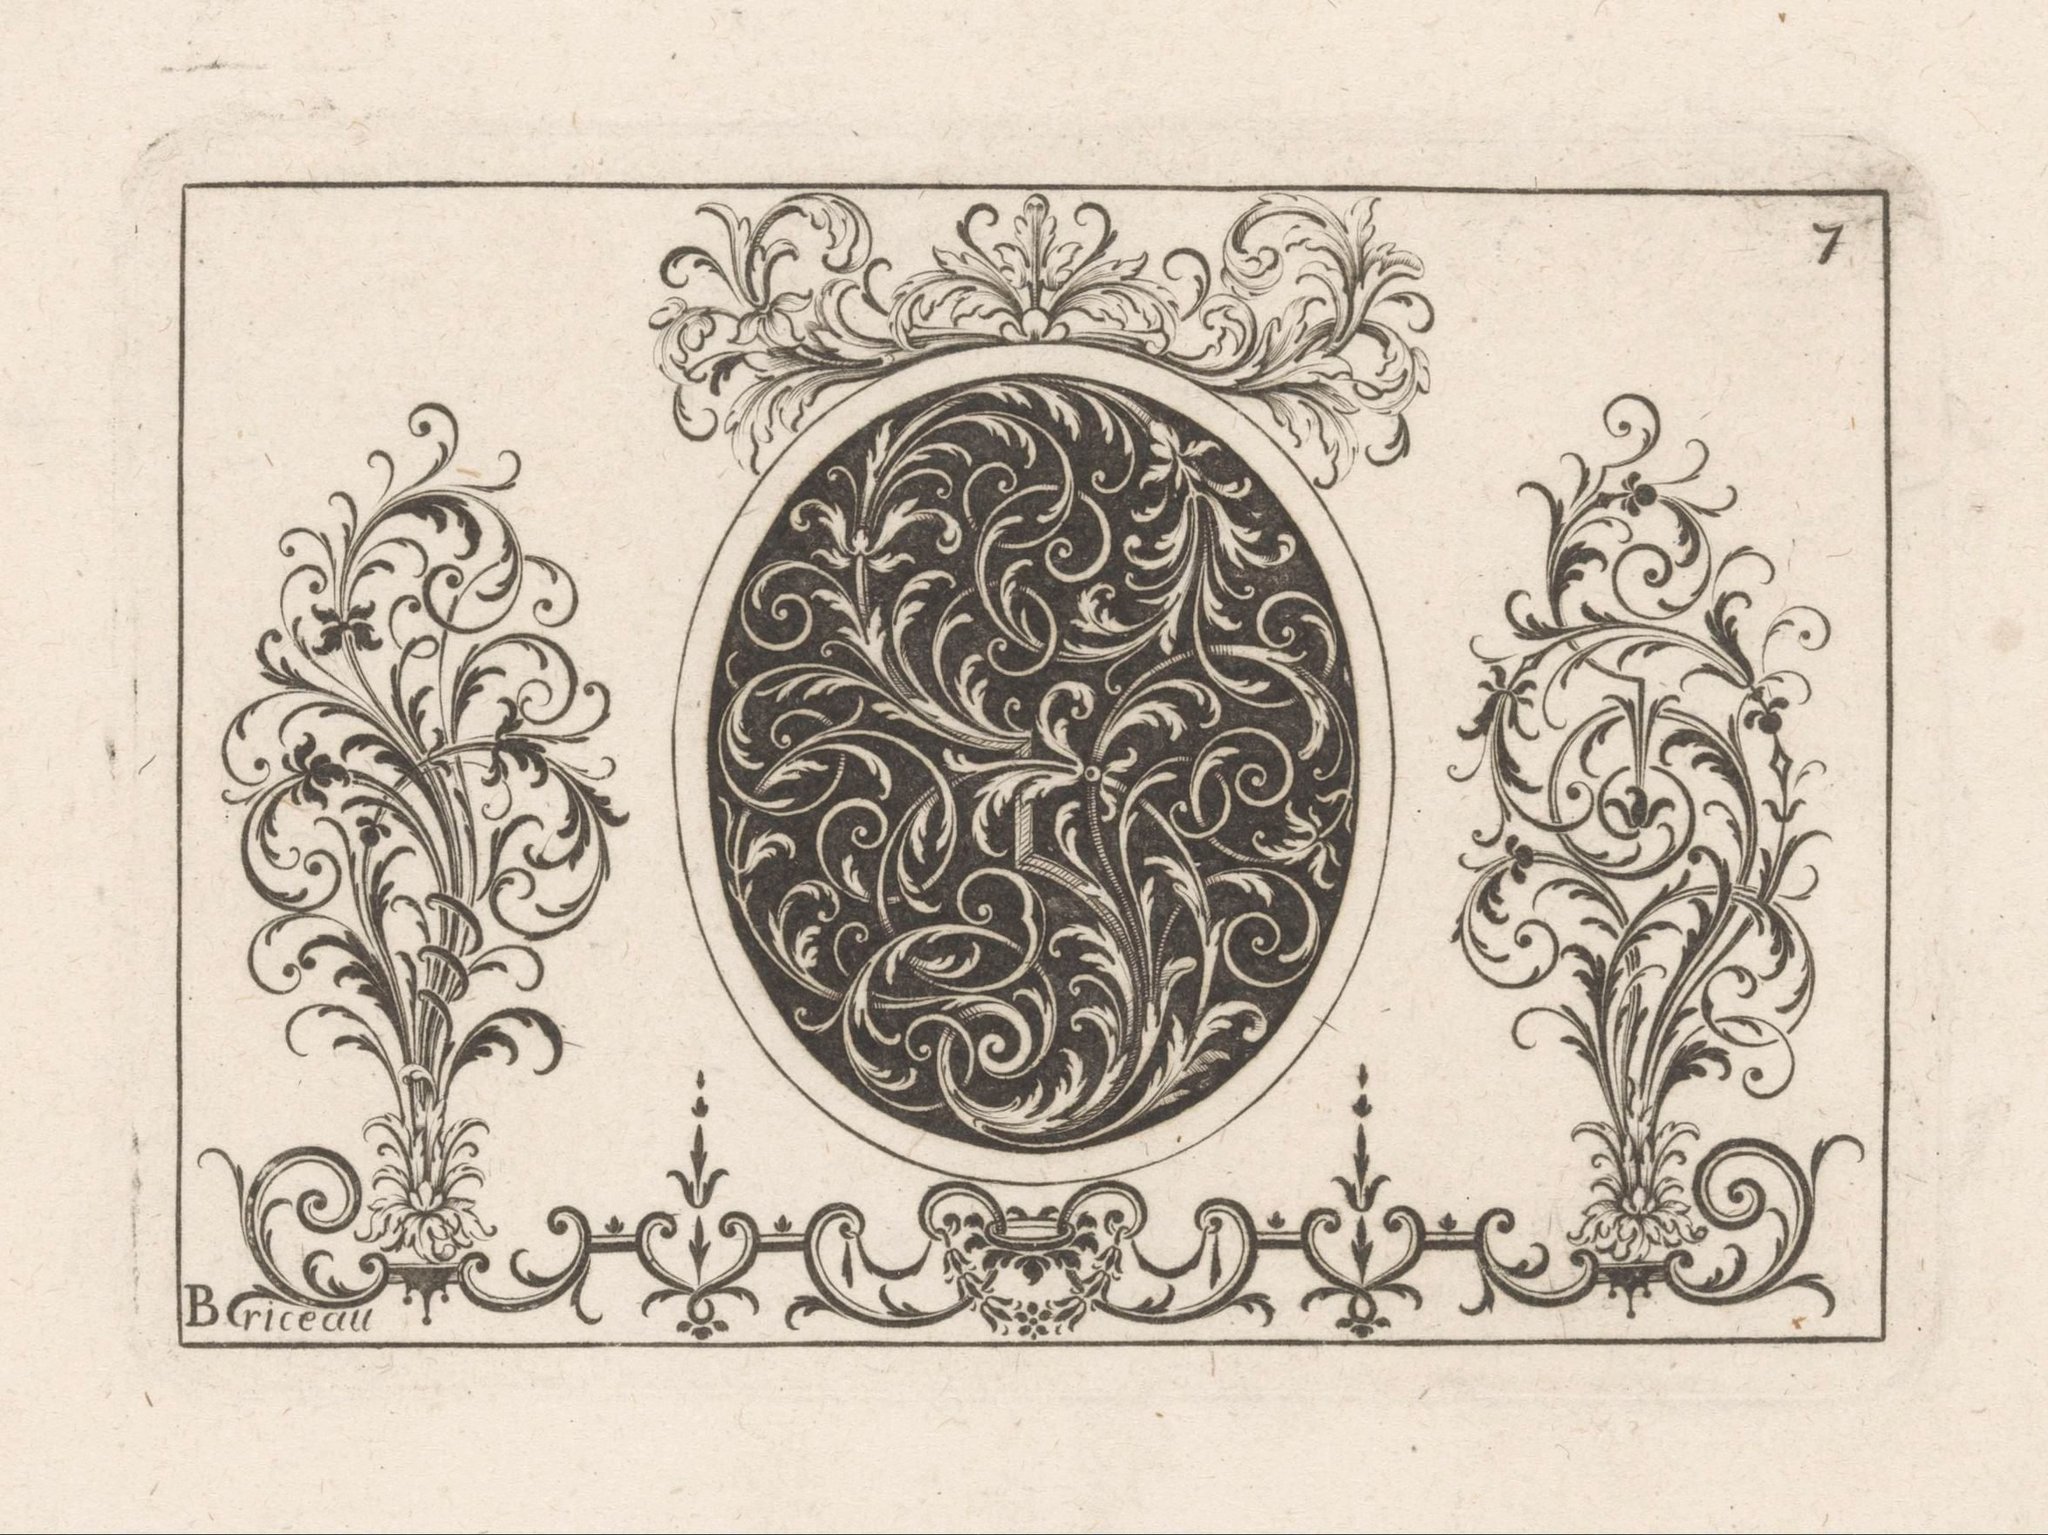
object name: ornament print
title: Medaillon en ornamenten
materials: paper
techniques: etching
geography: paris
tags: interlace ~ ornament, ornament ~ medallion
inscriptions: collector's mark: Lugt 2166, collector's mark: Lugt 2228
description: Een ovaal medaillon gevuld met vlechtwerk, omringd door ornamenten.